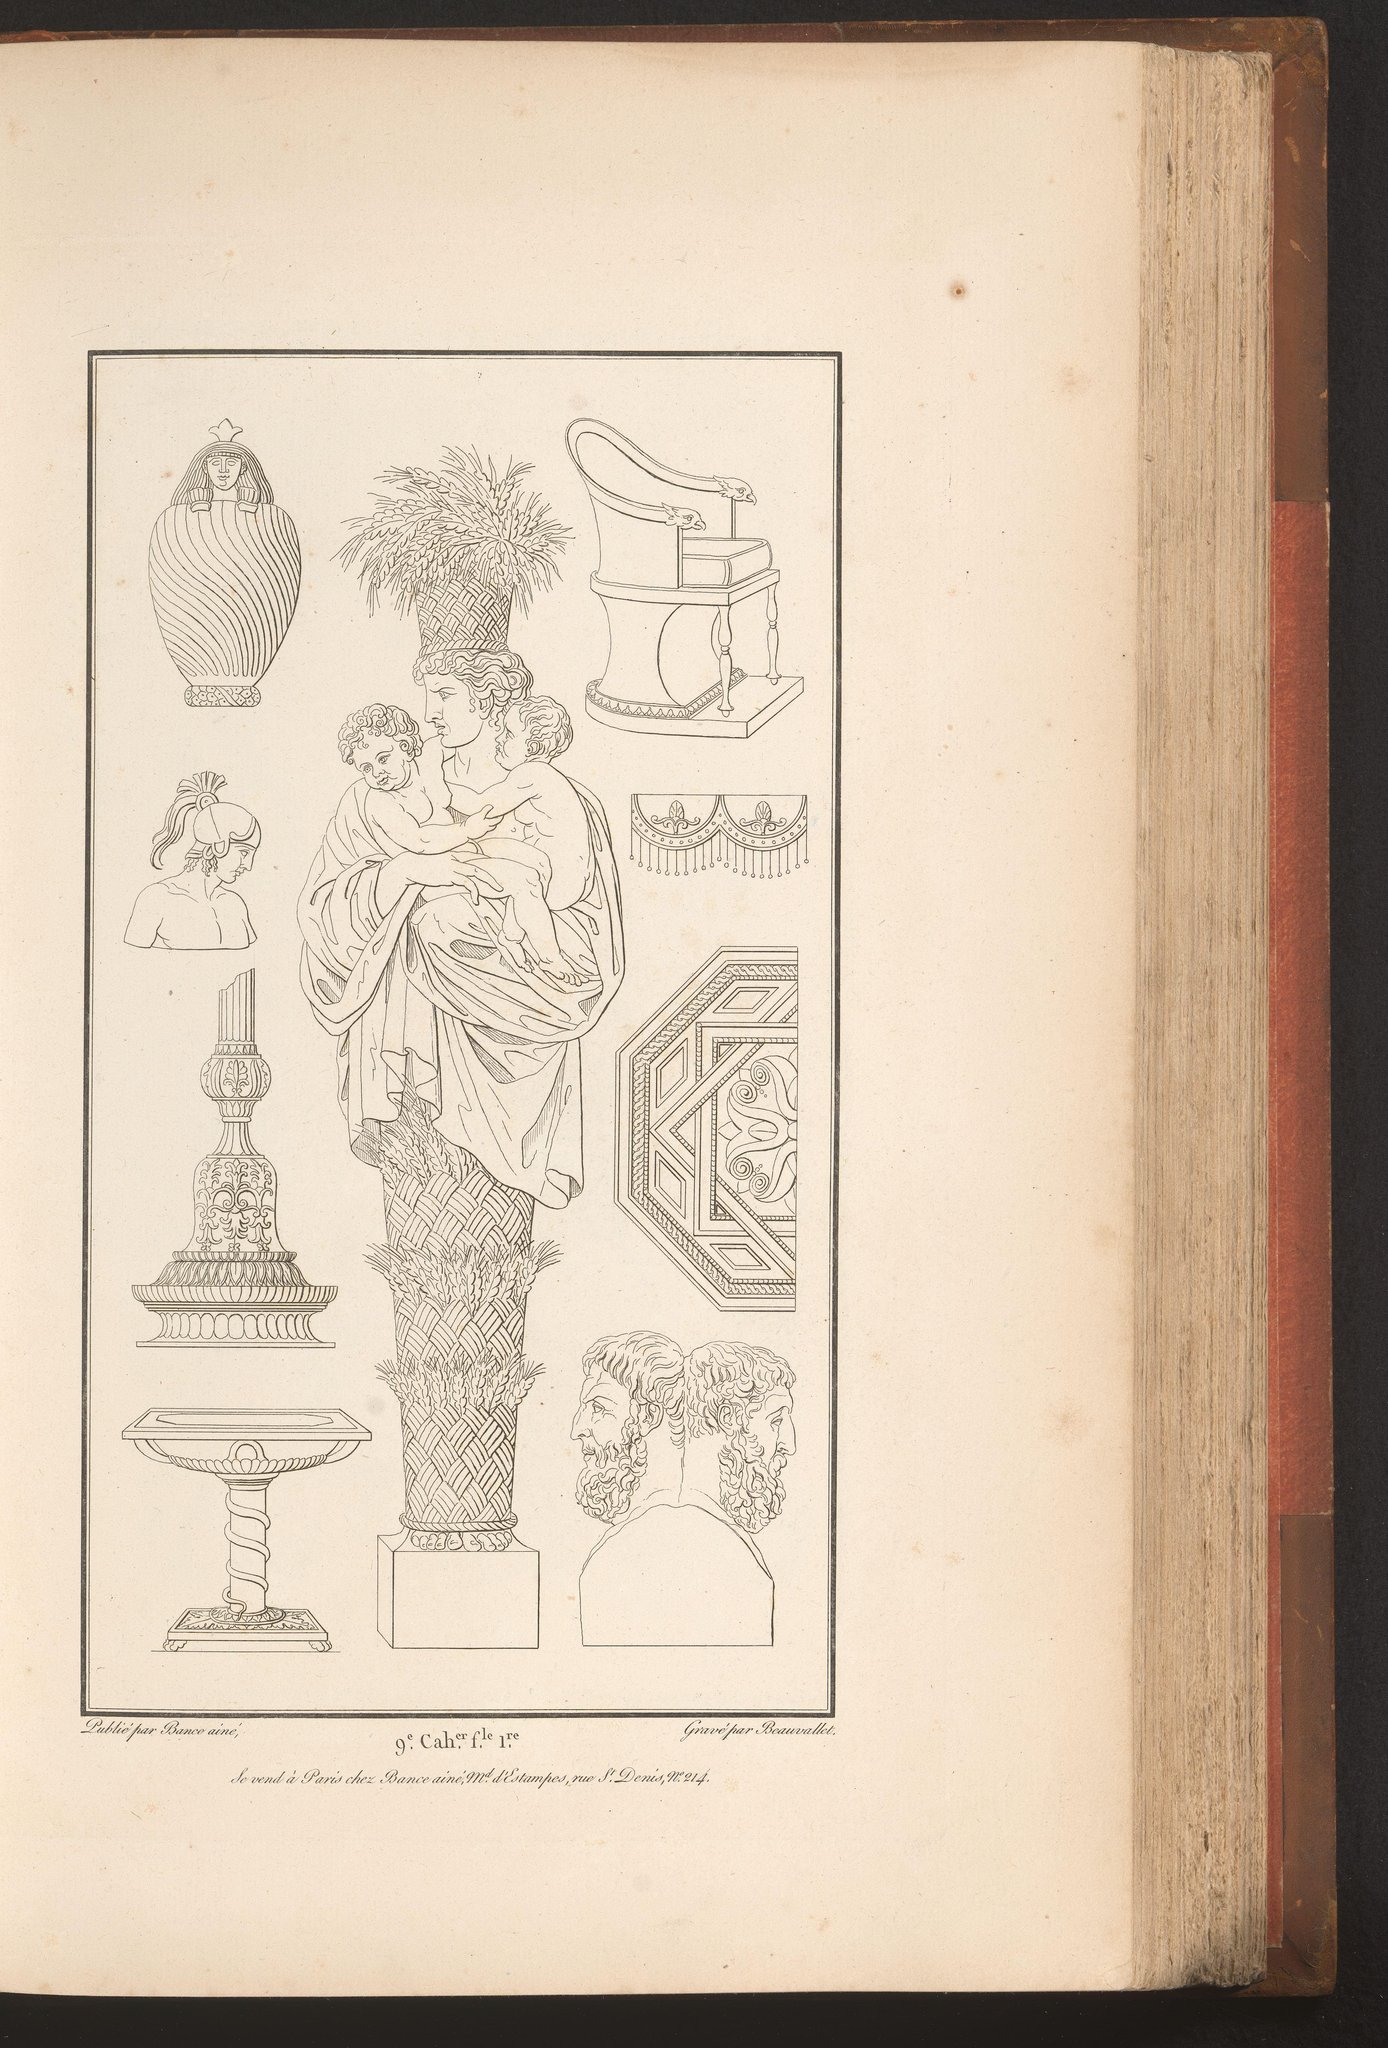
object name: ornament print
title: Diverse ornamenten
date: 1820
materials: paper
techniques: etching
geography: paris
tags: ornaments ~ art, piece of sculpture, reproduction of a piece of sculpture, ceres, patroness of agriculture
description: Ornamentprent met diverse objecten, centraal een beeld van Ceres met twee kinderen. Onderdeel (9e. Cah. f.le 1) van het prentalbum met twee series van in totaal 138 ornamentprenten door Beauvallet en Normand, 'Fragmens d'Ornemens dans le Style Antique'.